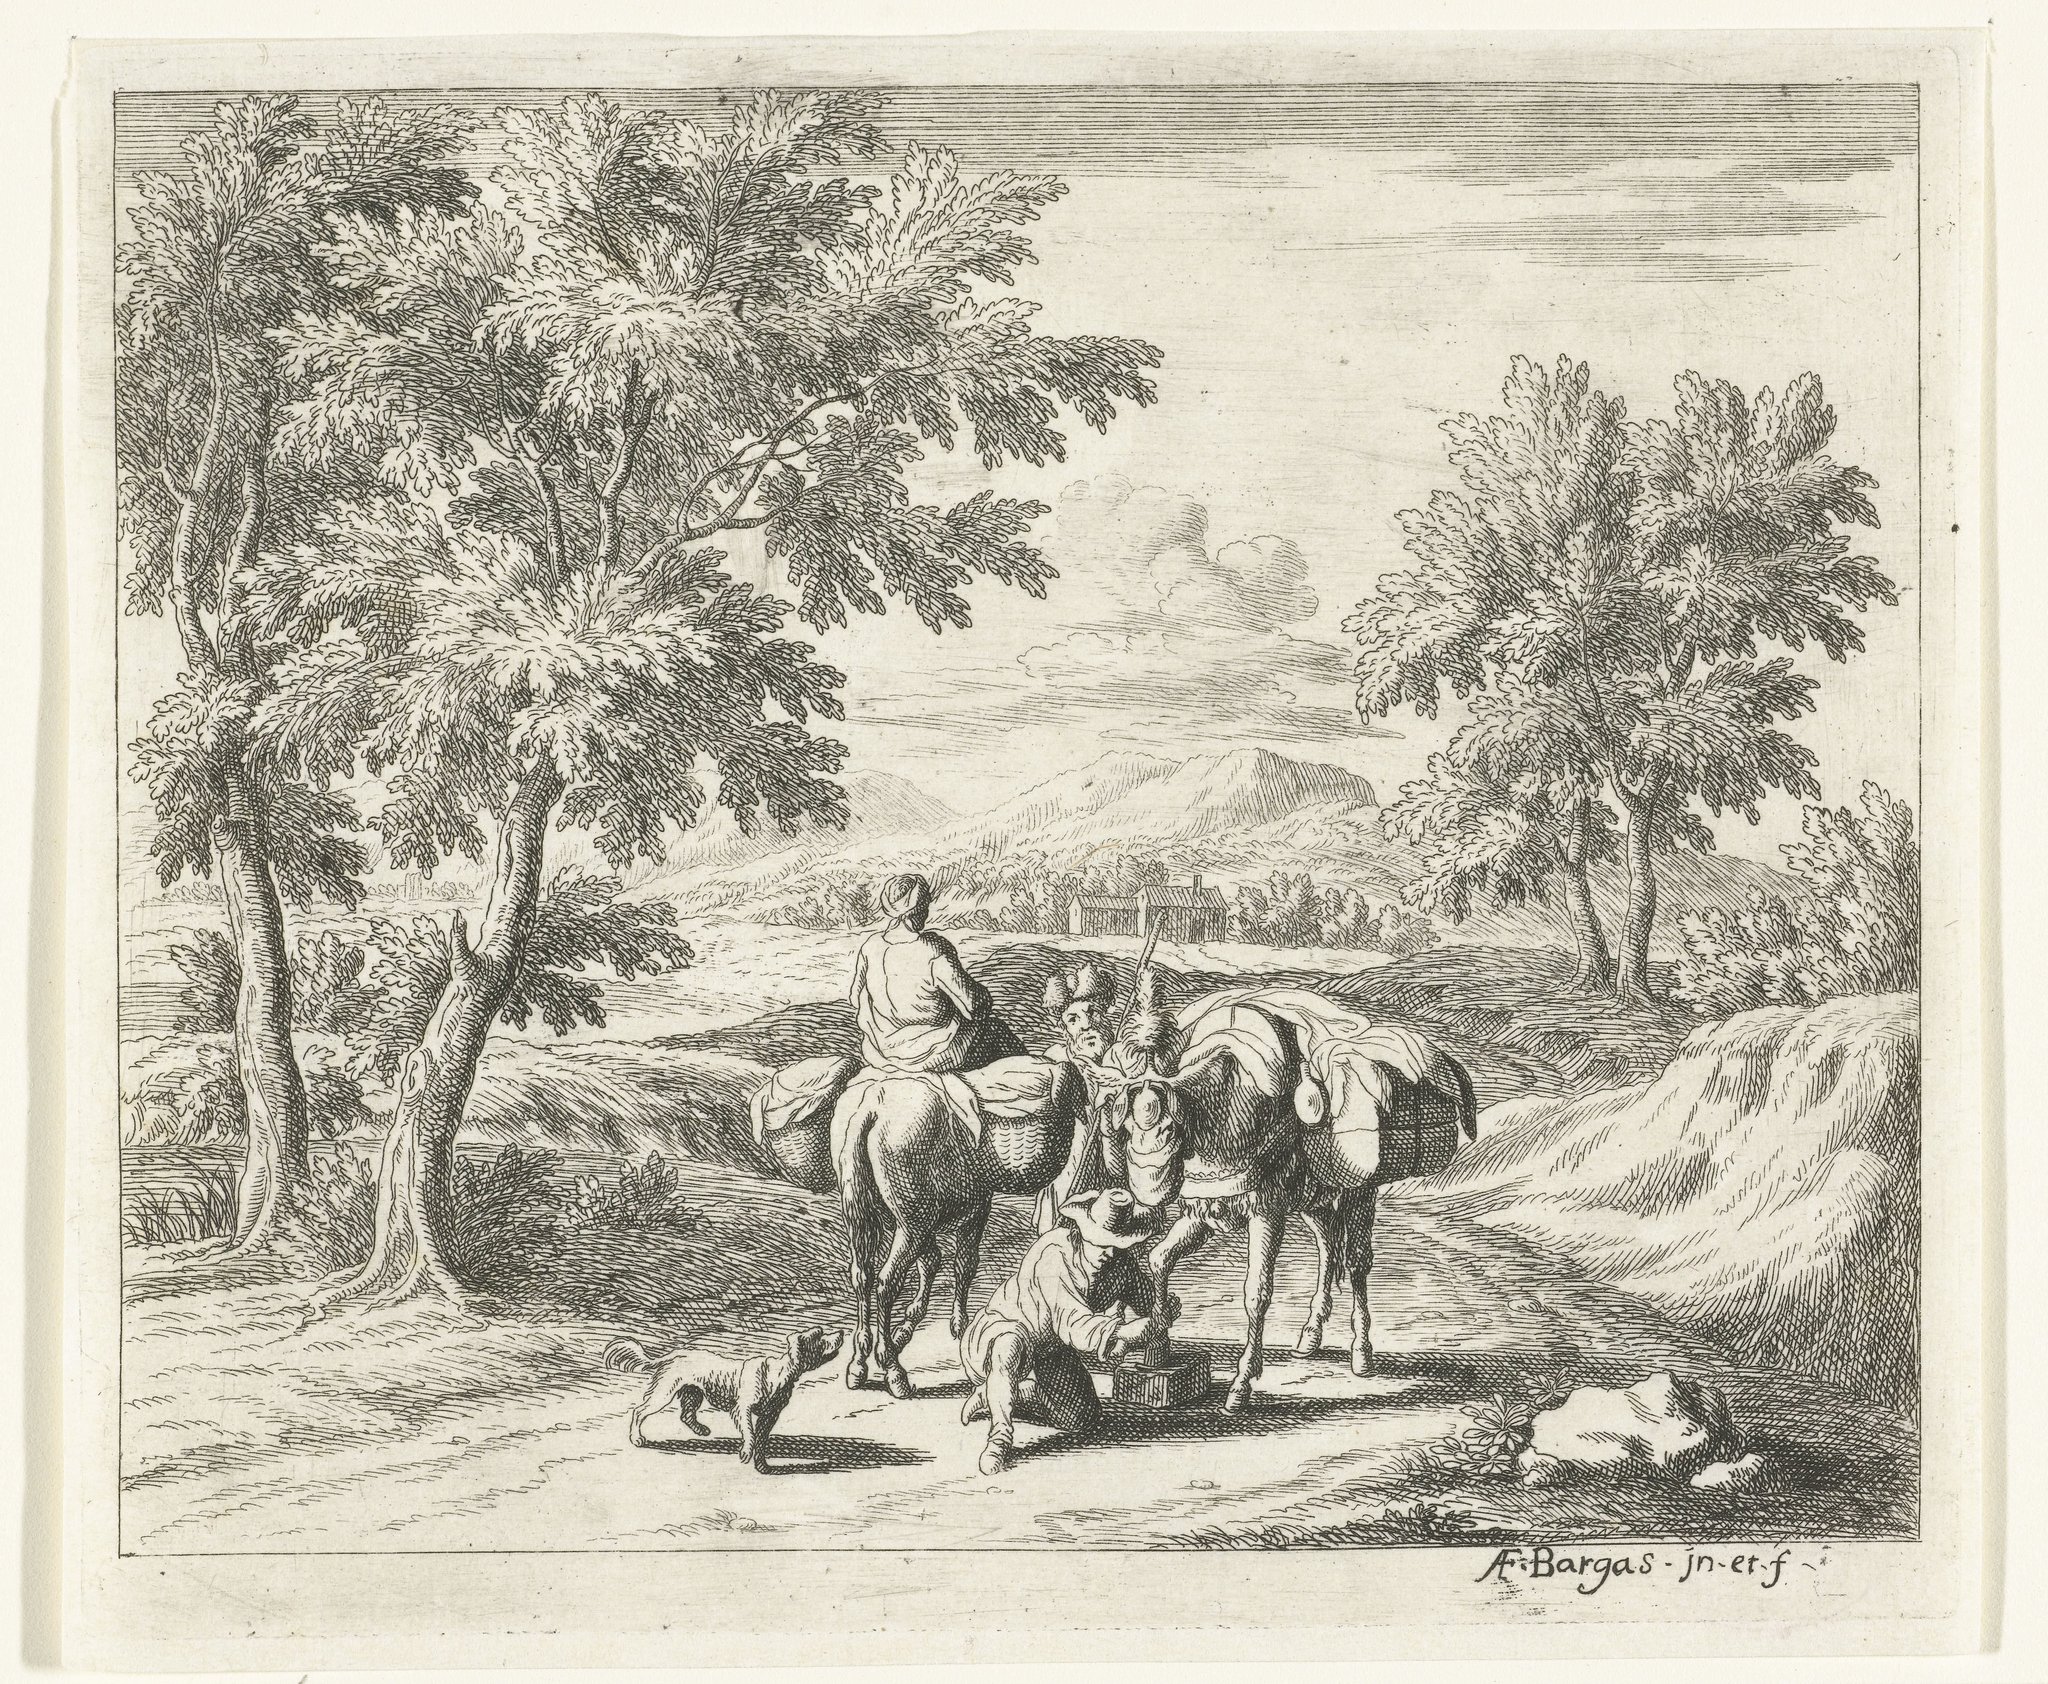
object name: print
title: Landschap met muilezeldrijver die poot van ezel verzorgt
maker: franciscus de bargas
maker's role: draughtsman, painter, print maker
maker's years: 1667-1723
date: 1660-1699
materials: paper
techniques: etching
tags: pack-animal, mule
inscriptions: collector's mark: Lugt 240